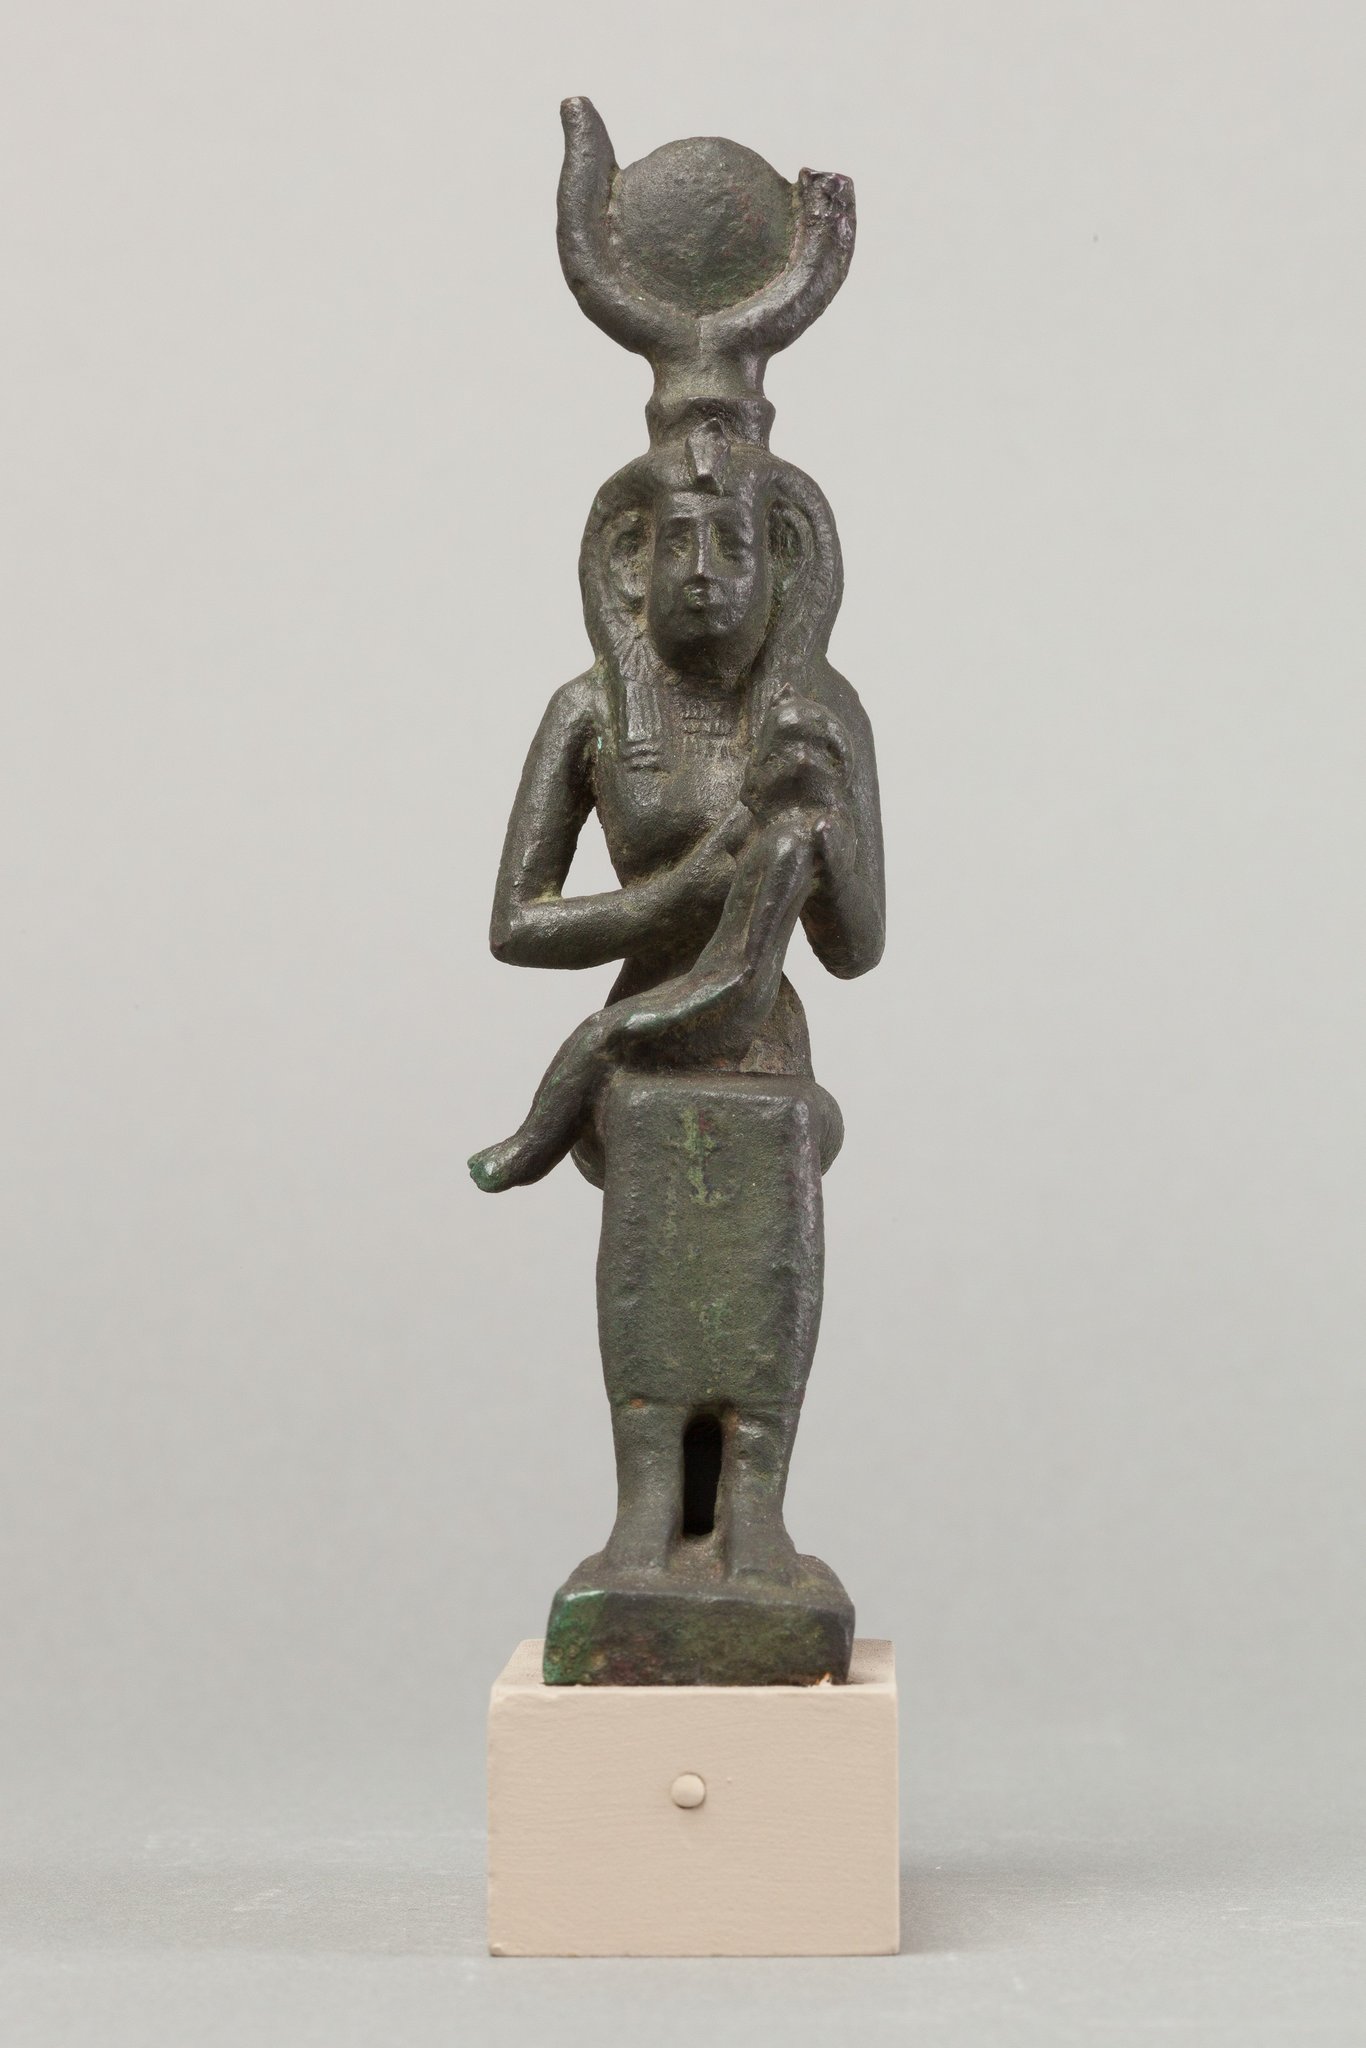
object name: statuette, isi, horus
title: Isis and Horus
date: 664-630 BCE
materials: metal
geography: egypt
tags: horus,isis,nursing